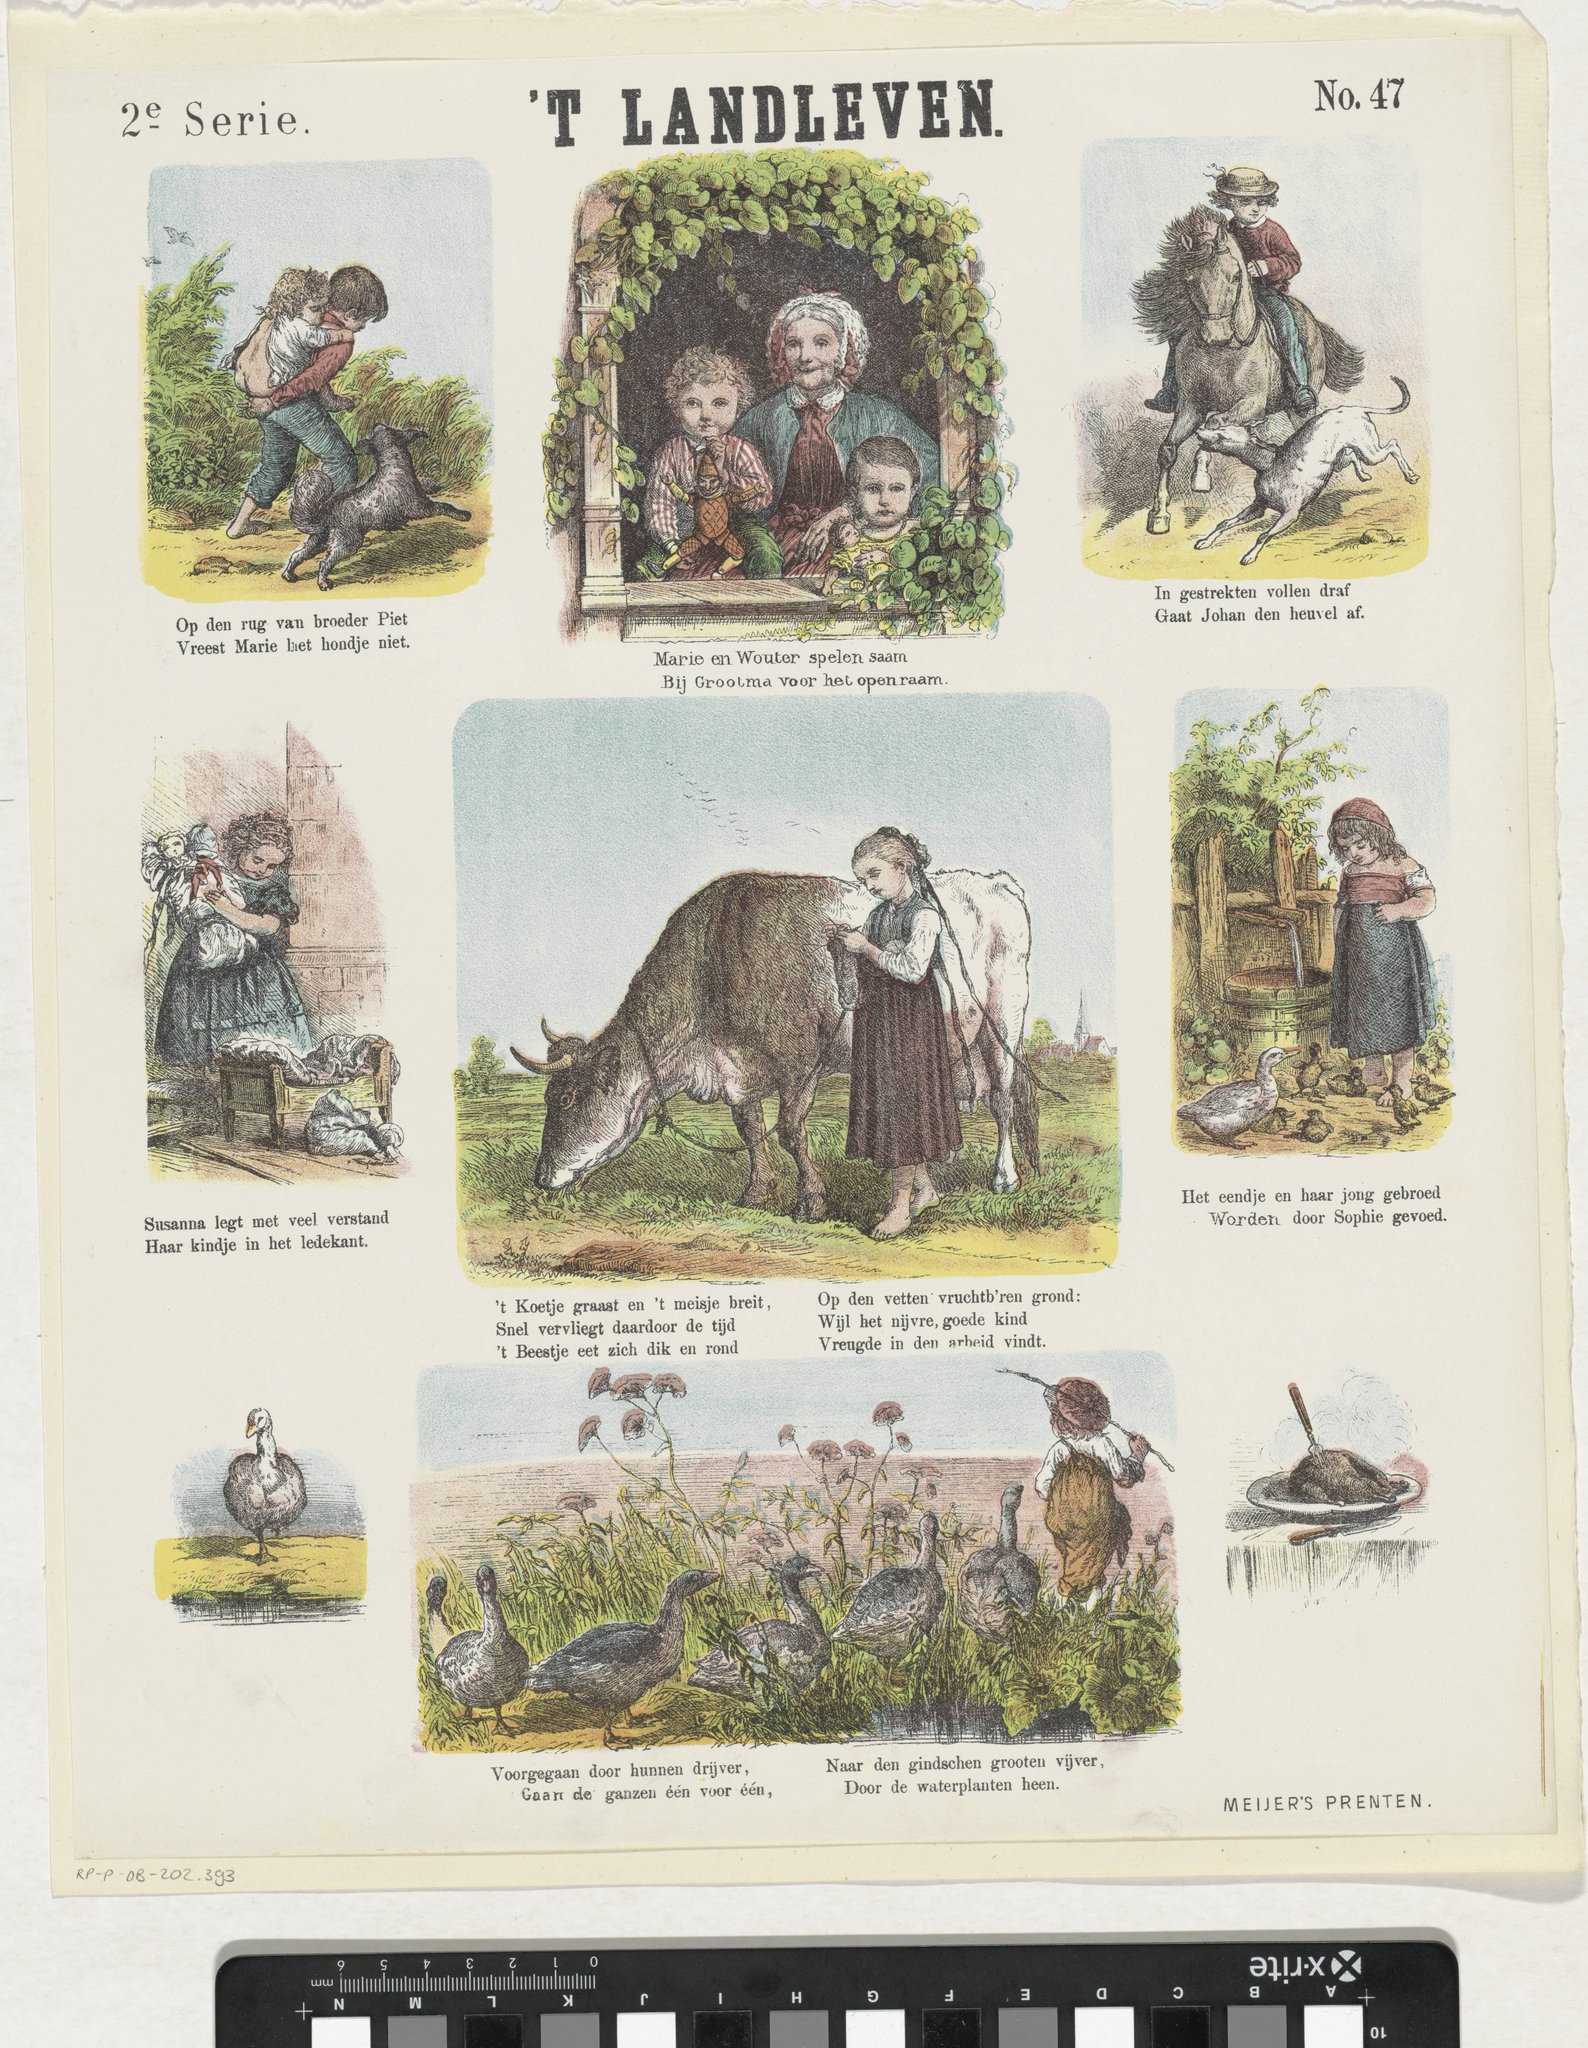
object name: print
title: Meijer's prenten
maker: Anonymous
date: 1874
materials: paper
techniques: lithograph, letterpress printing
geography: amsterdam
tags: animals, child, (playing with) dolls, child playing with animals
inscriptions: collector's mark: Lugt 2760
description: Blad met 9 landelijke taferelen met kinderen en dieren. Onder elke afbeelding een vers. Genummerd rechtsboven: No. 47.